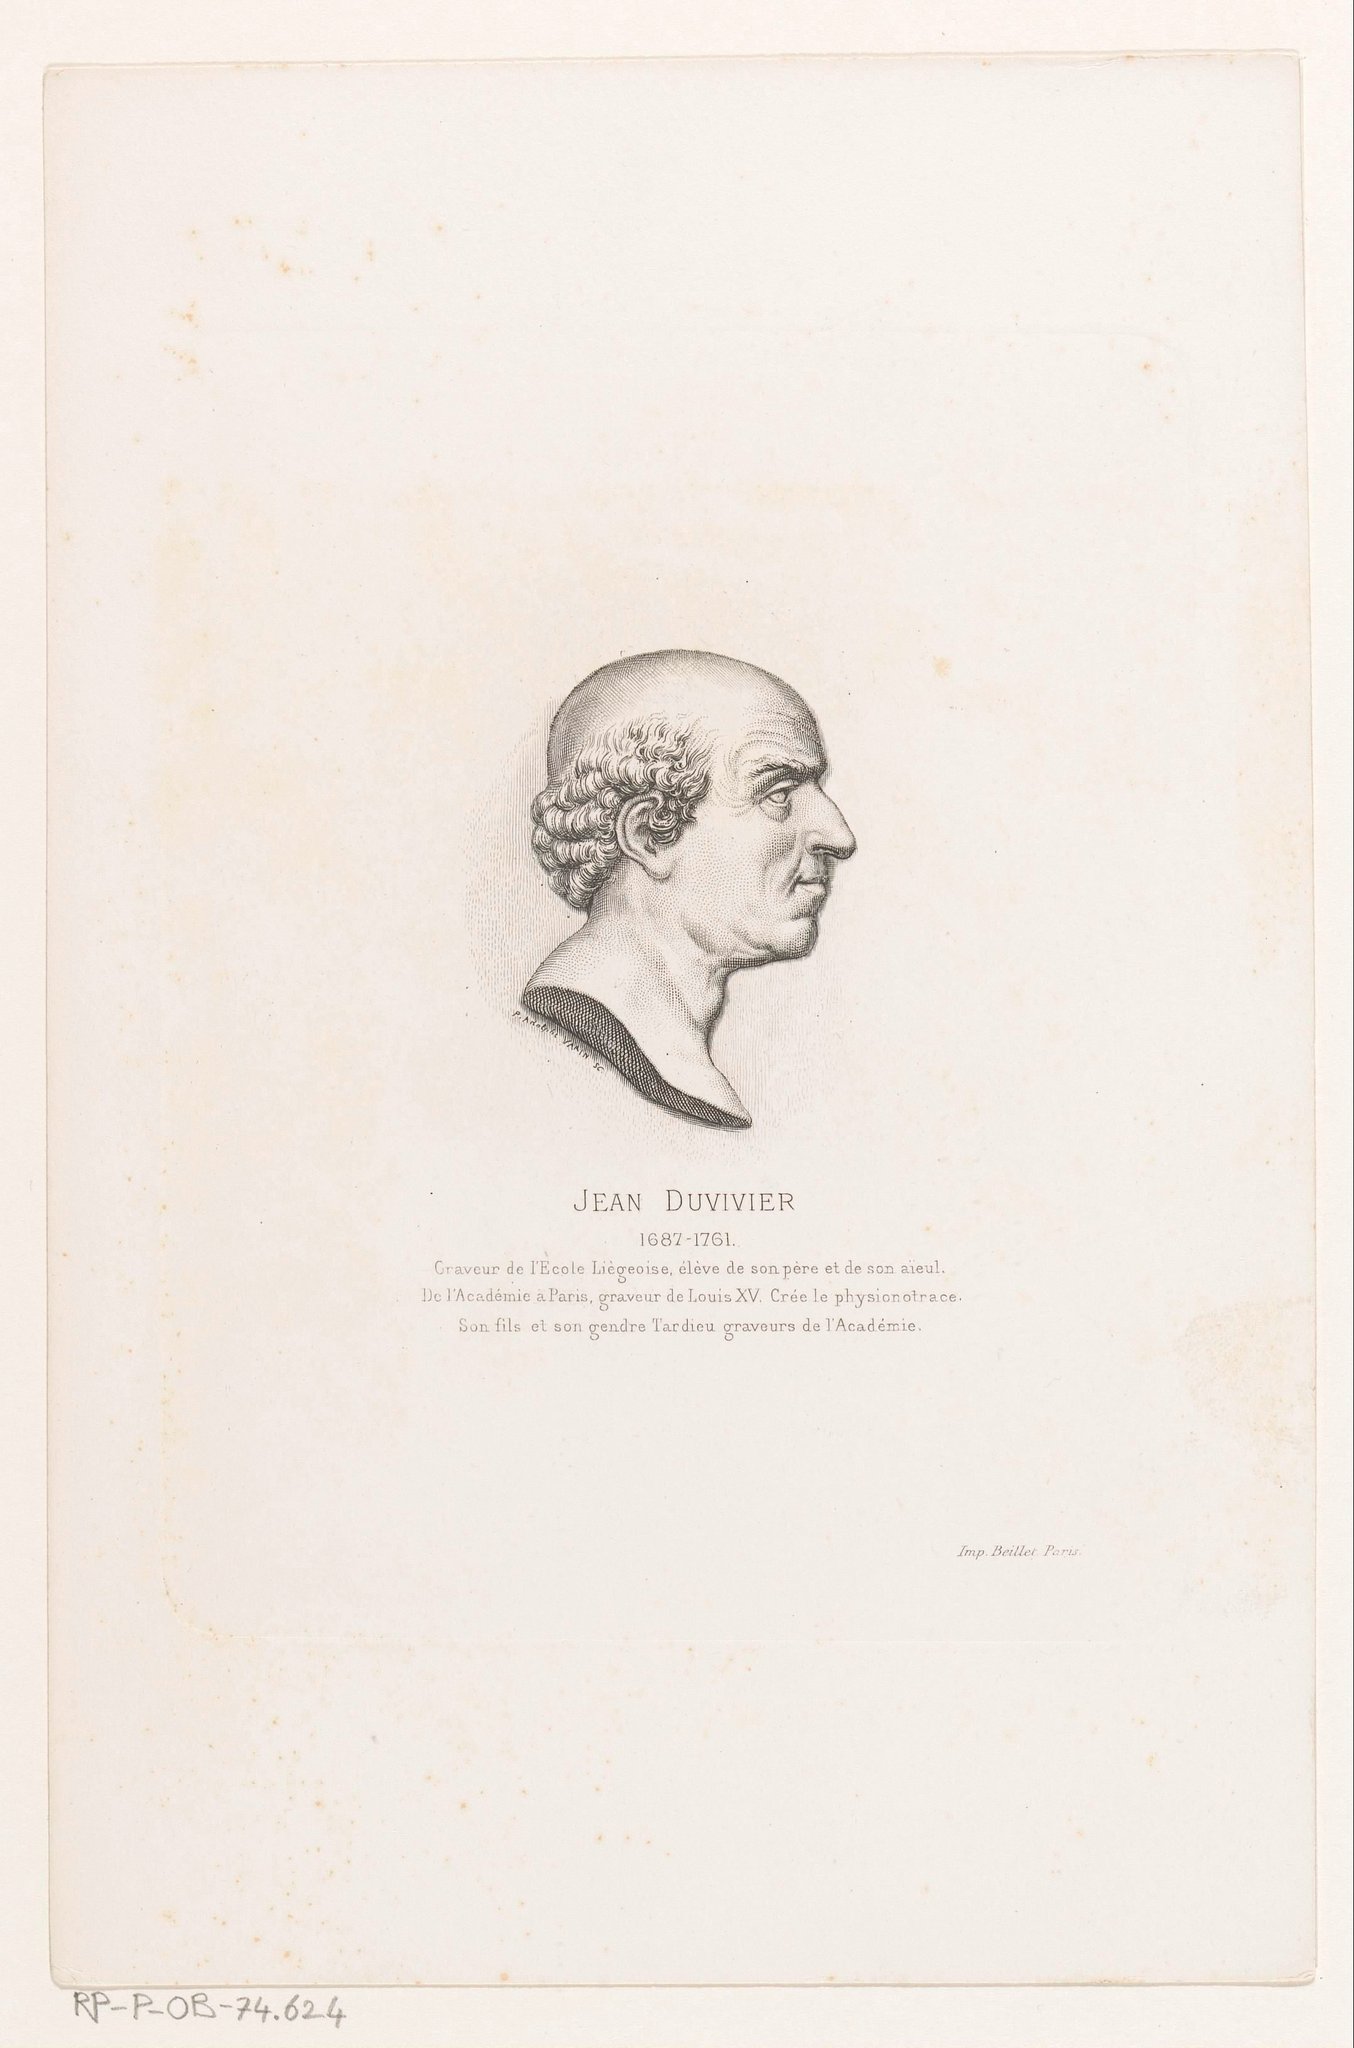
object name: book illustration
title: Portretbuste van Jean Duvivier en profil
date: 1884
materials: paper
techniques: engraving, etching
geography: paris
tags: paris, jean duvivier, historical persons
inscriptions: collector's mark: Lugt 2228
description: Prent uit: École liégeoise. Les Graveurs. Leurs portraits, reproduits au burin, d'après les originaux, par Adolphe Varin, 1366-1850. Avec notes historiques (...). Parijs: Fr. Gobbaerts, ca. 1684.